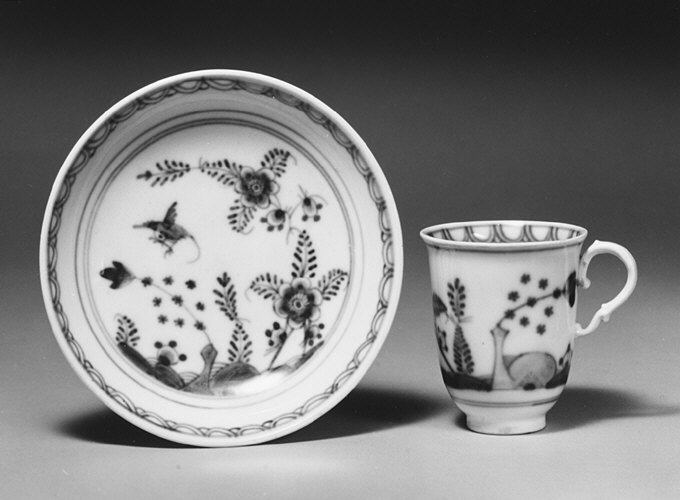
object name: cup and saucer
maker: imperial porcelain manufactory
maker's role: manufactory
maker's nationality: austrian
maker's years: 1744-1864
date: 1765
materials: hard paste porcelain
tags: birds,flowers